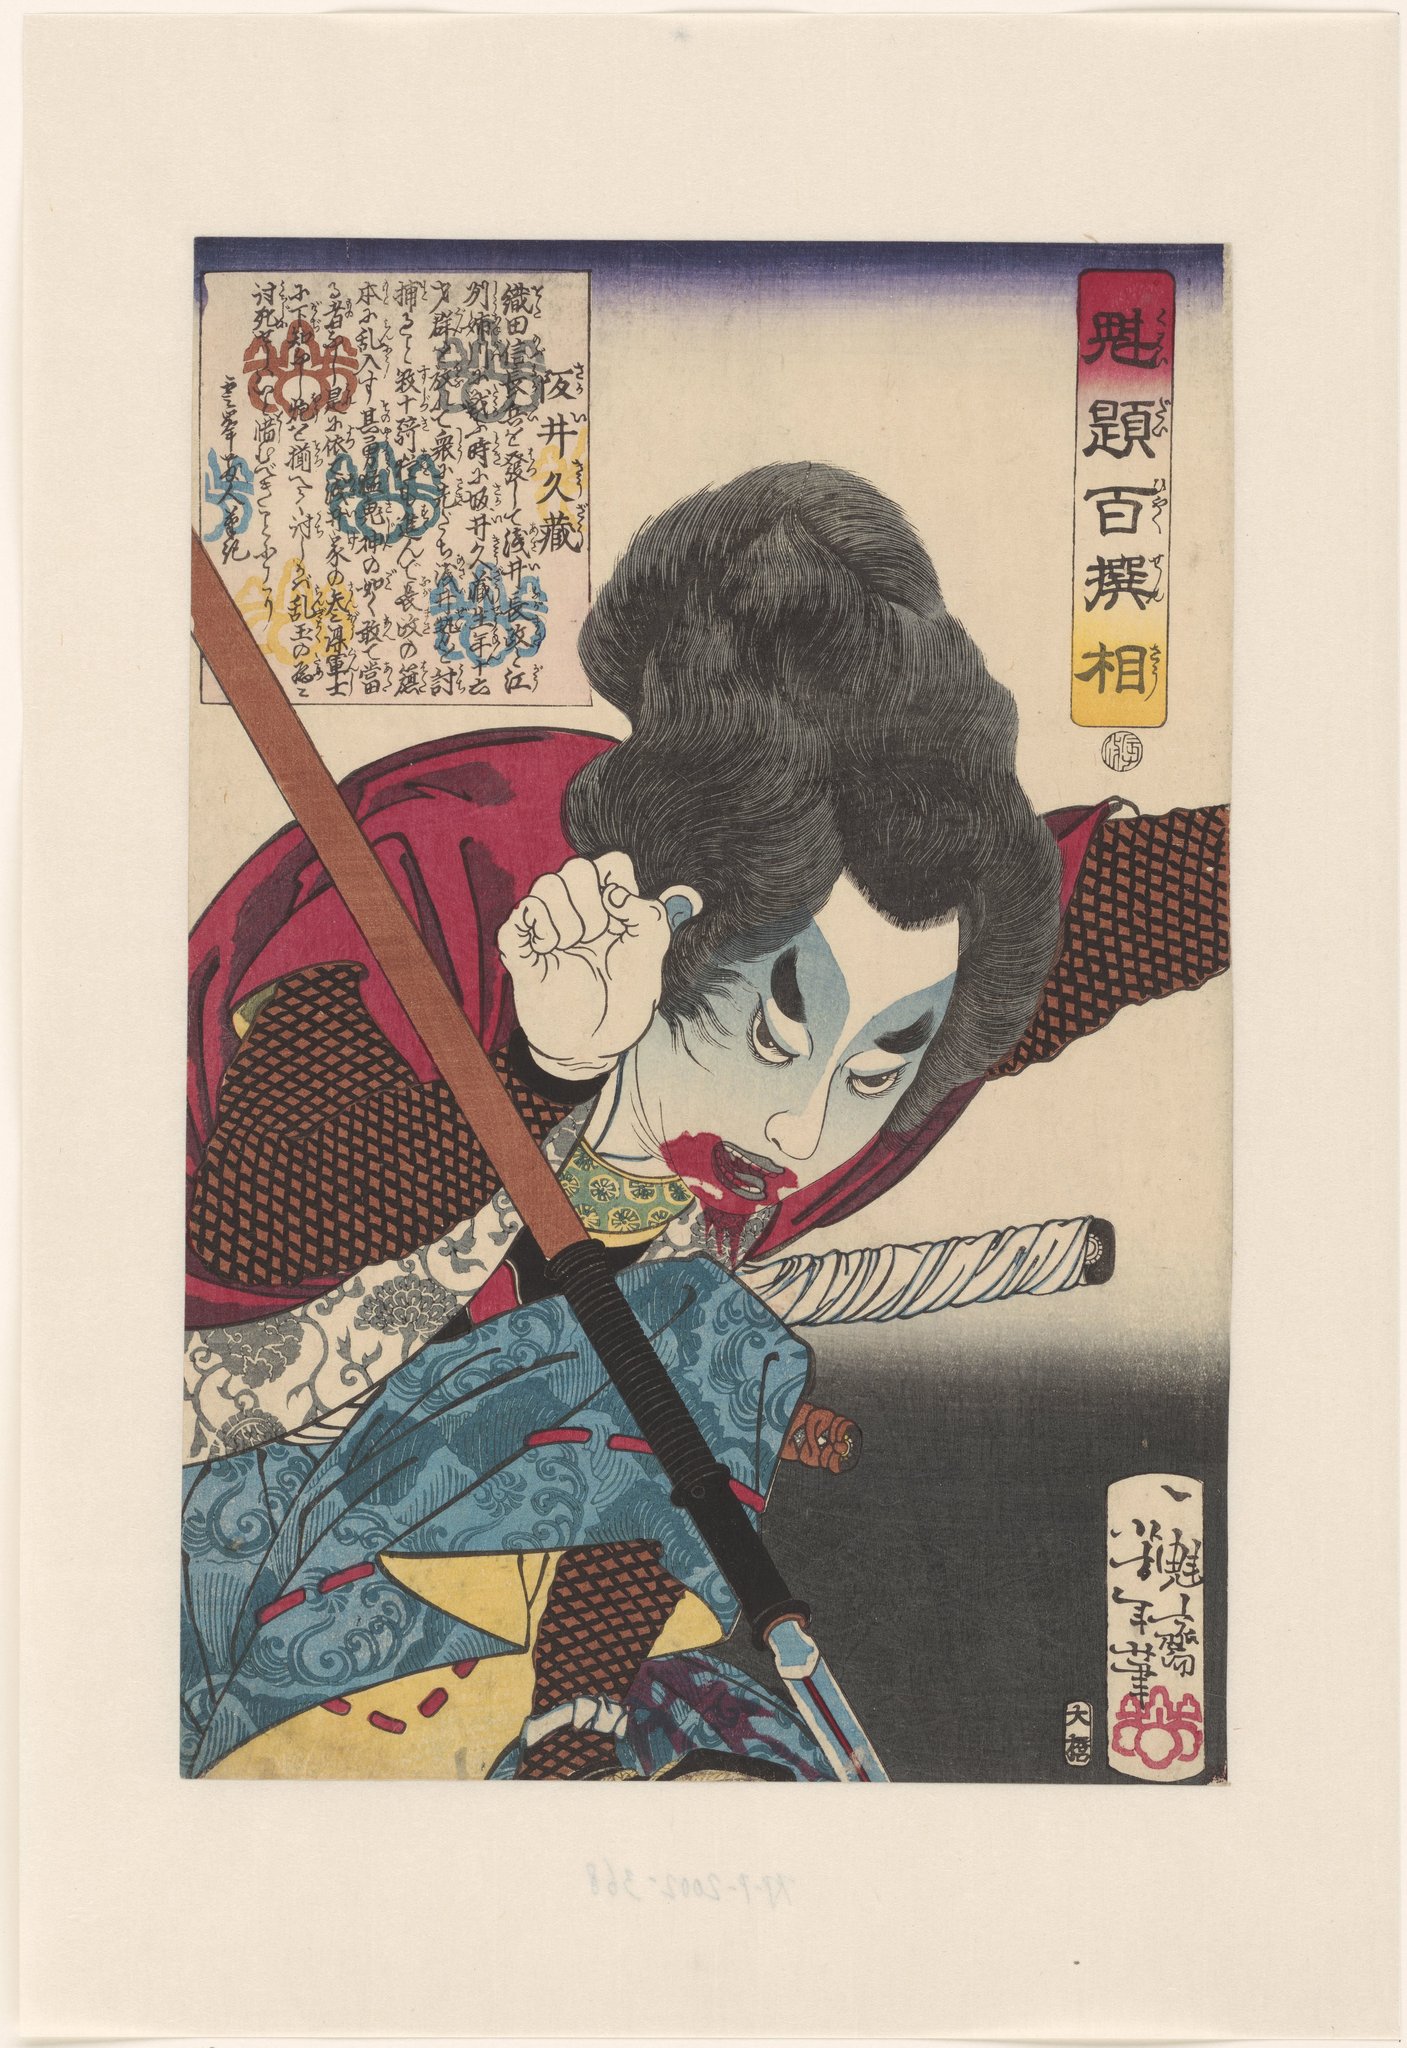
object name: print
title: Sakai Kyuzo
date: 1810-1868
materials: paper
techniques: woodcut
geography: japan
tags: adult man, casting weapons: spear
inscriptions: collector's mark: Lugt 2228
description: Sakai Kyuzo, met blauw-wit geschminkt gezicht en bloed bij de mond, werpt een speer.